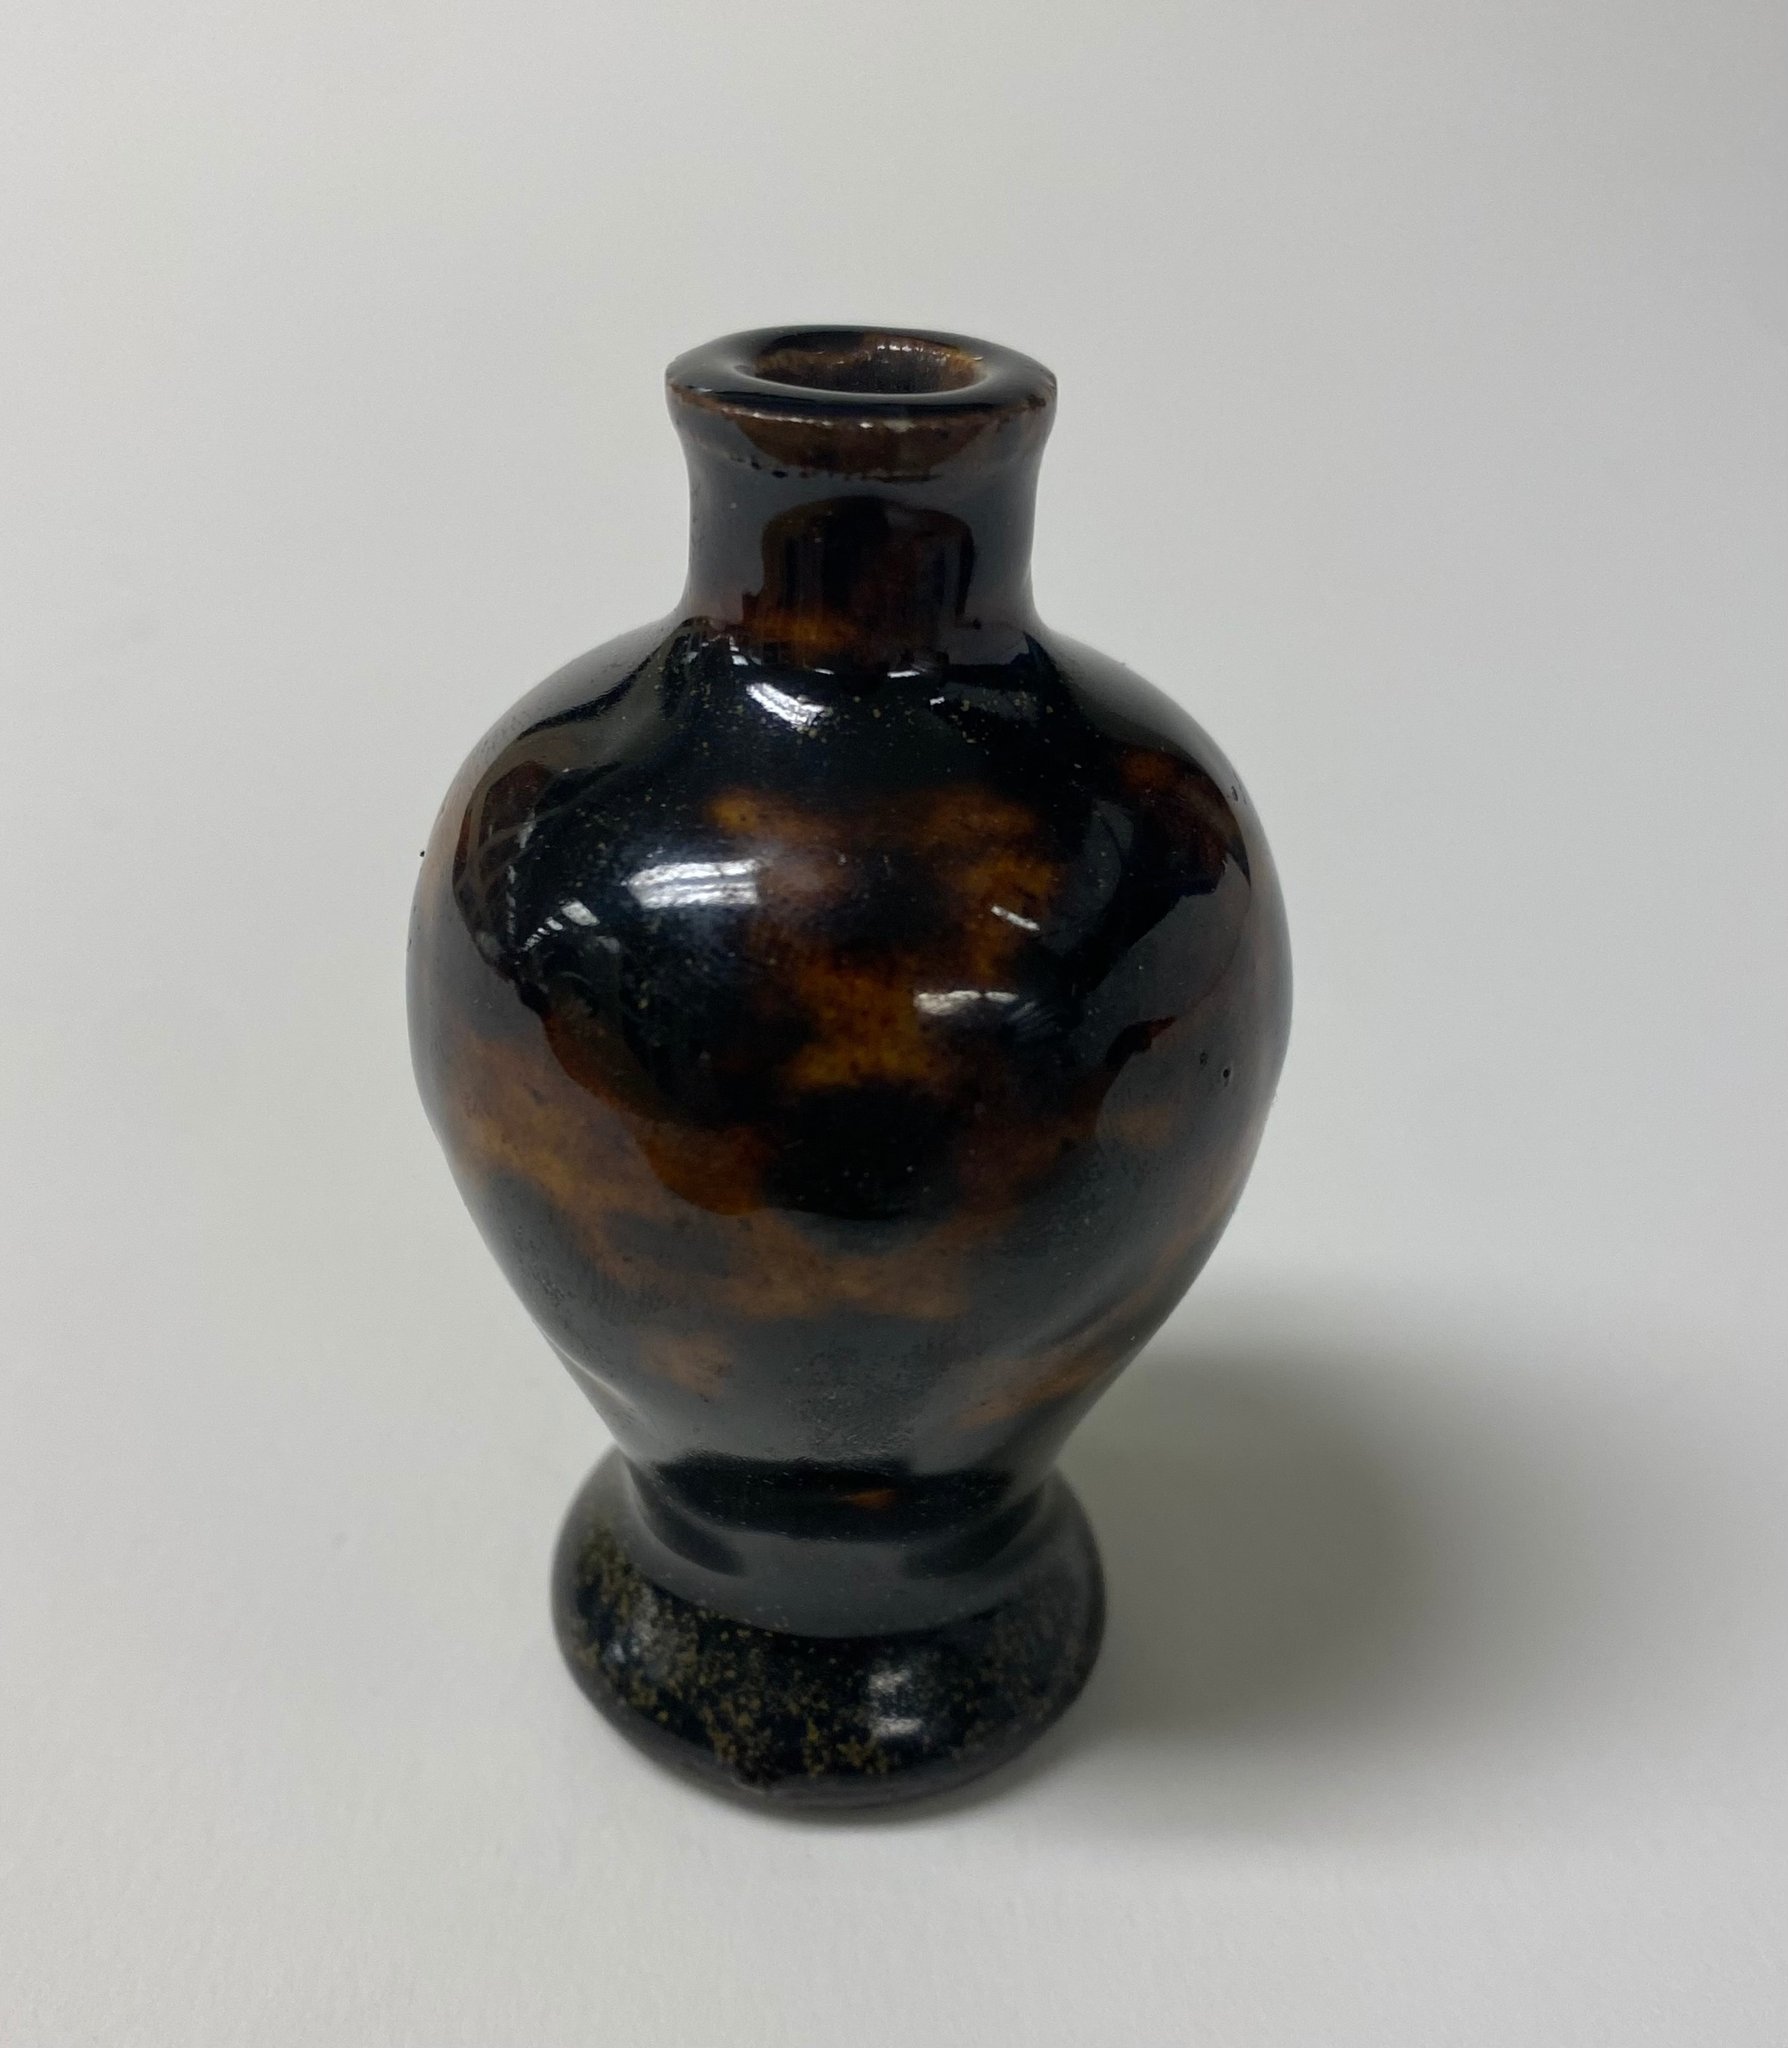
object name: vase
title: Minature meiping vase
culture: chinese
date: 1801-1900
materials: glaze, porcelain